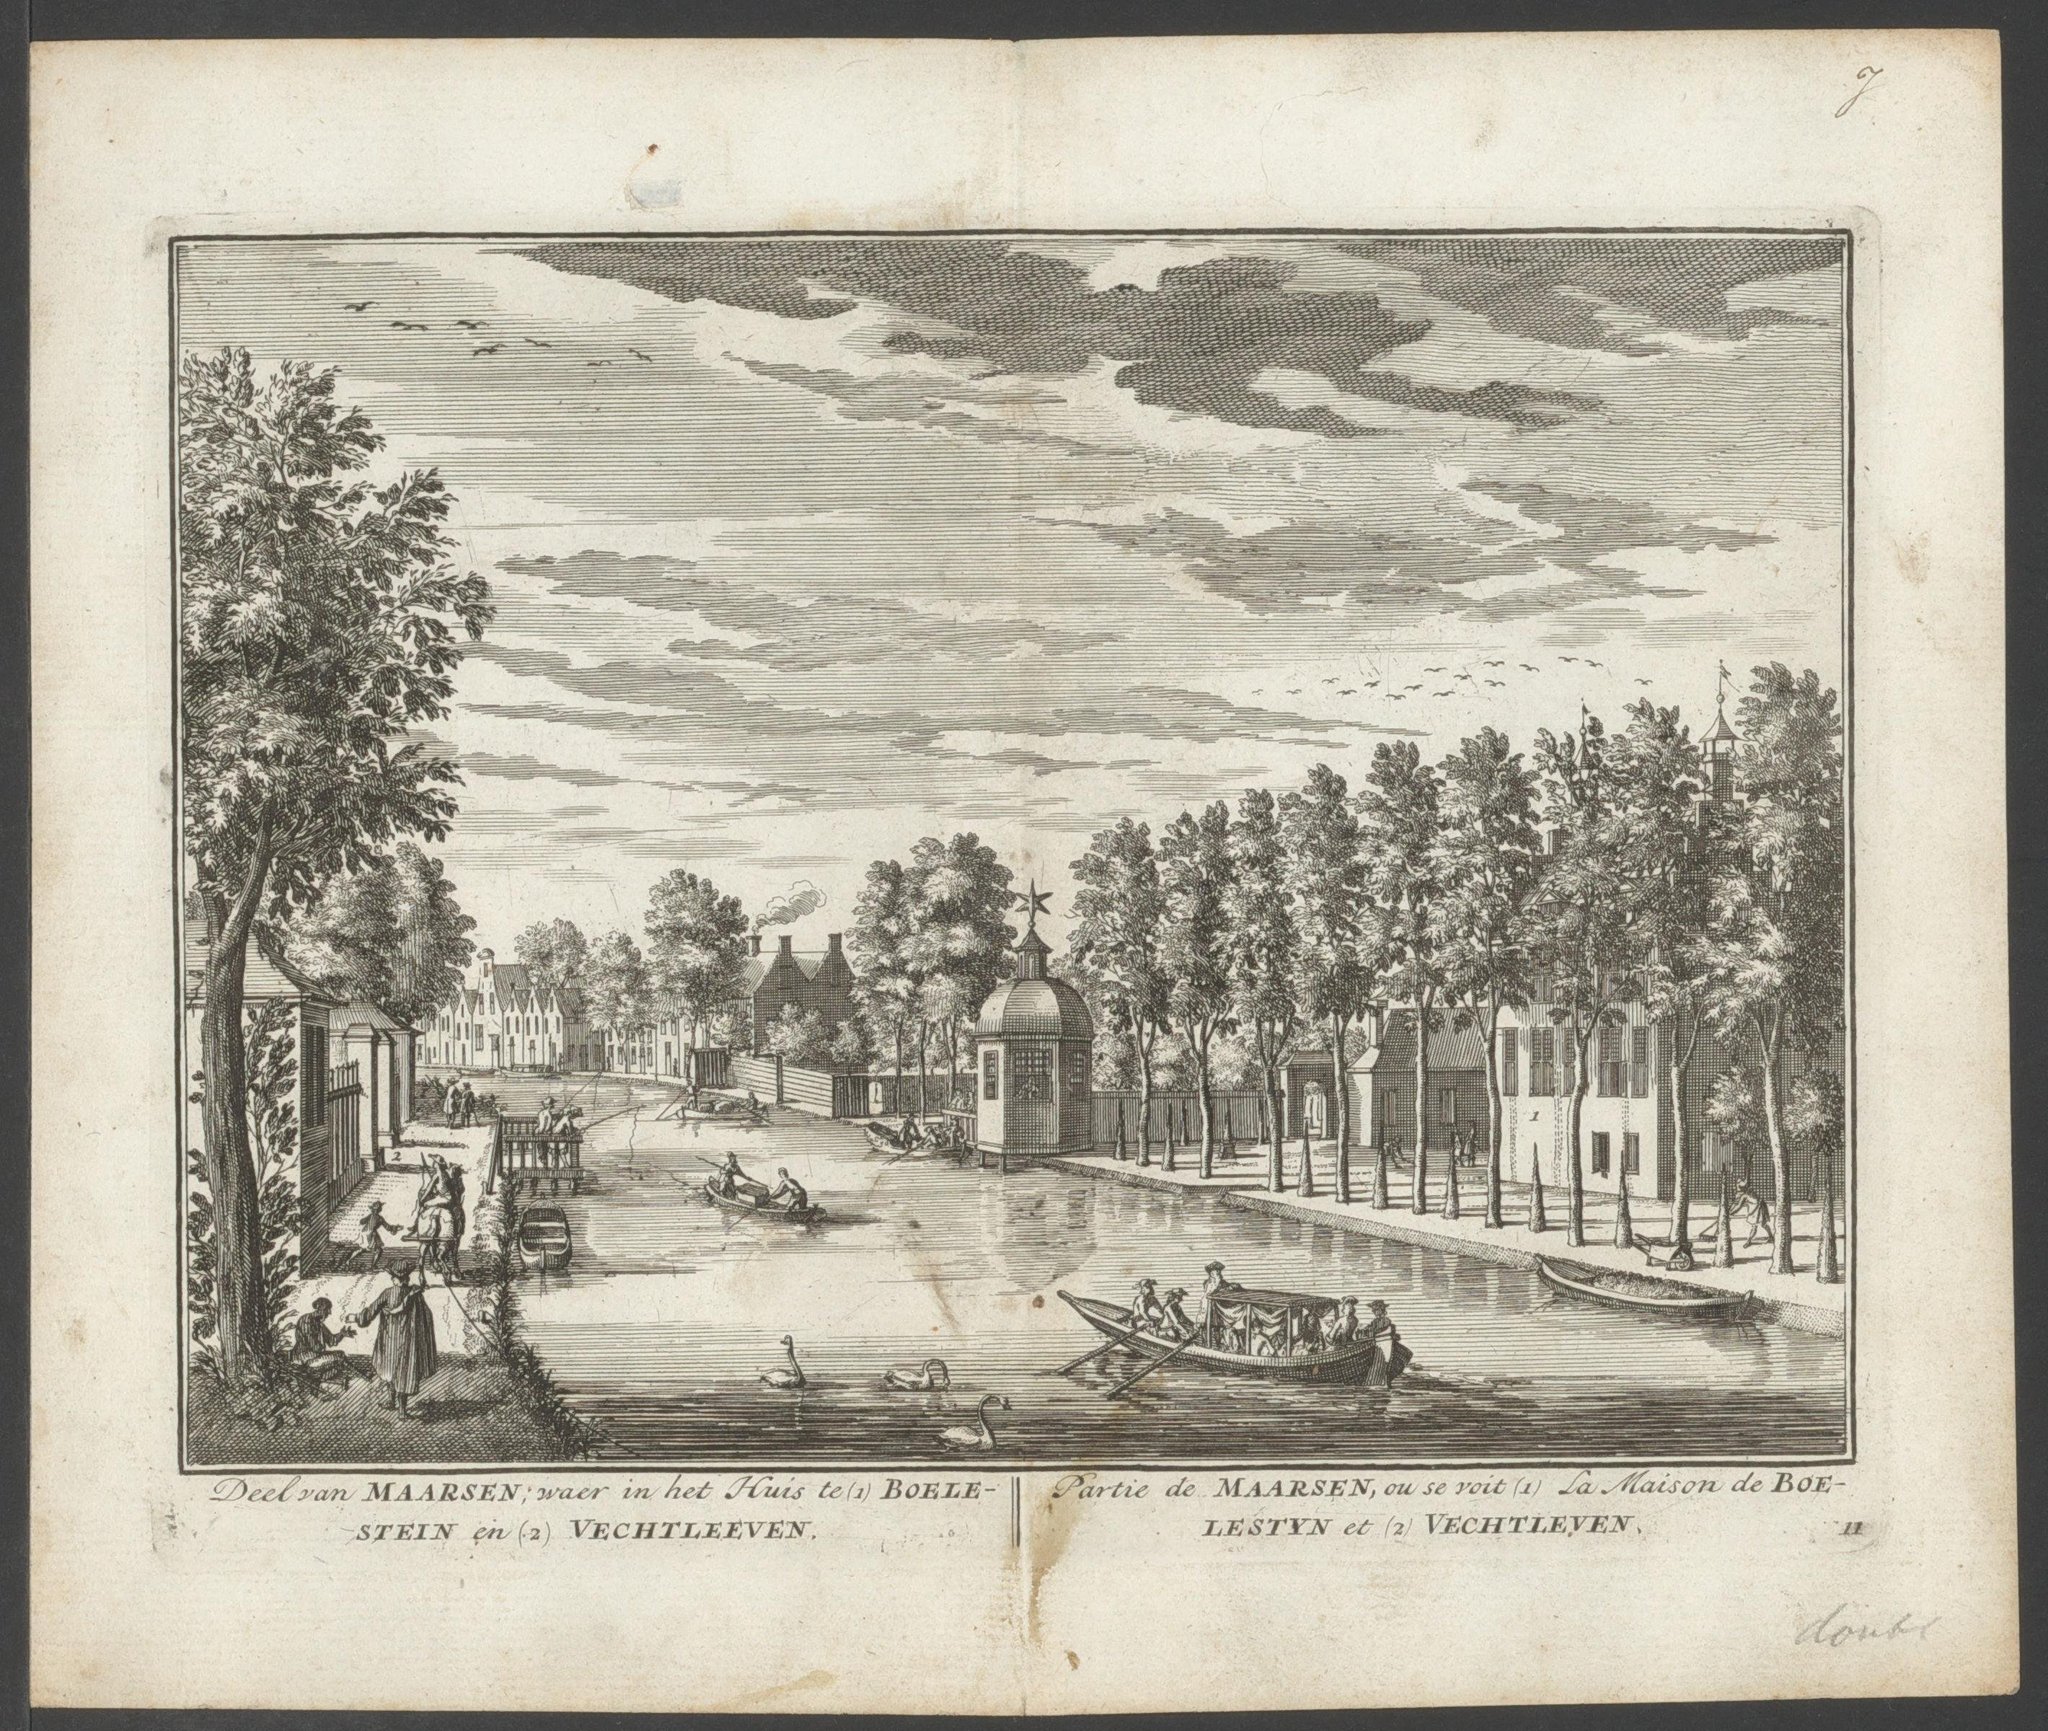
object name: print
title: Deel van Maarsen; waer in het Huis te (1) Boelestein en (2) Vechtleeven / Partie de Maarsen, ou se voit (1) La Maison de Boelestyn et (2) Vechtleven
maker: daniël stopendaal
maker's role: print maker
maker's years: 1672-1726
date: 1790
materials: paper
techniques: engraving, etching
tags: rural housing, e.g. country-house, villa, cottage, river (+ landscape with figures, staffage), maarssen, vecht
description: Prent mogelijk uit: Leth, Andries de. De zegepraalende Vecht, vertoonende verscheidene gesichten van lustplaatsen, heeren huysen en dorpen, beginnende van Uitrecht en met Muyden besluytende (...). Amsterdam: Weduwe Nicolaus Visscher, 1719. Of uit: Brouërius van Nidek, Matthaeus. De Vechtstroom, van Utrecht tot Muiden (...). Amsterdam: H. Gartman, W. Vermandel en J.W. Smit, 1790.